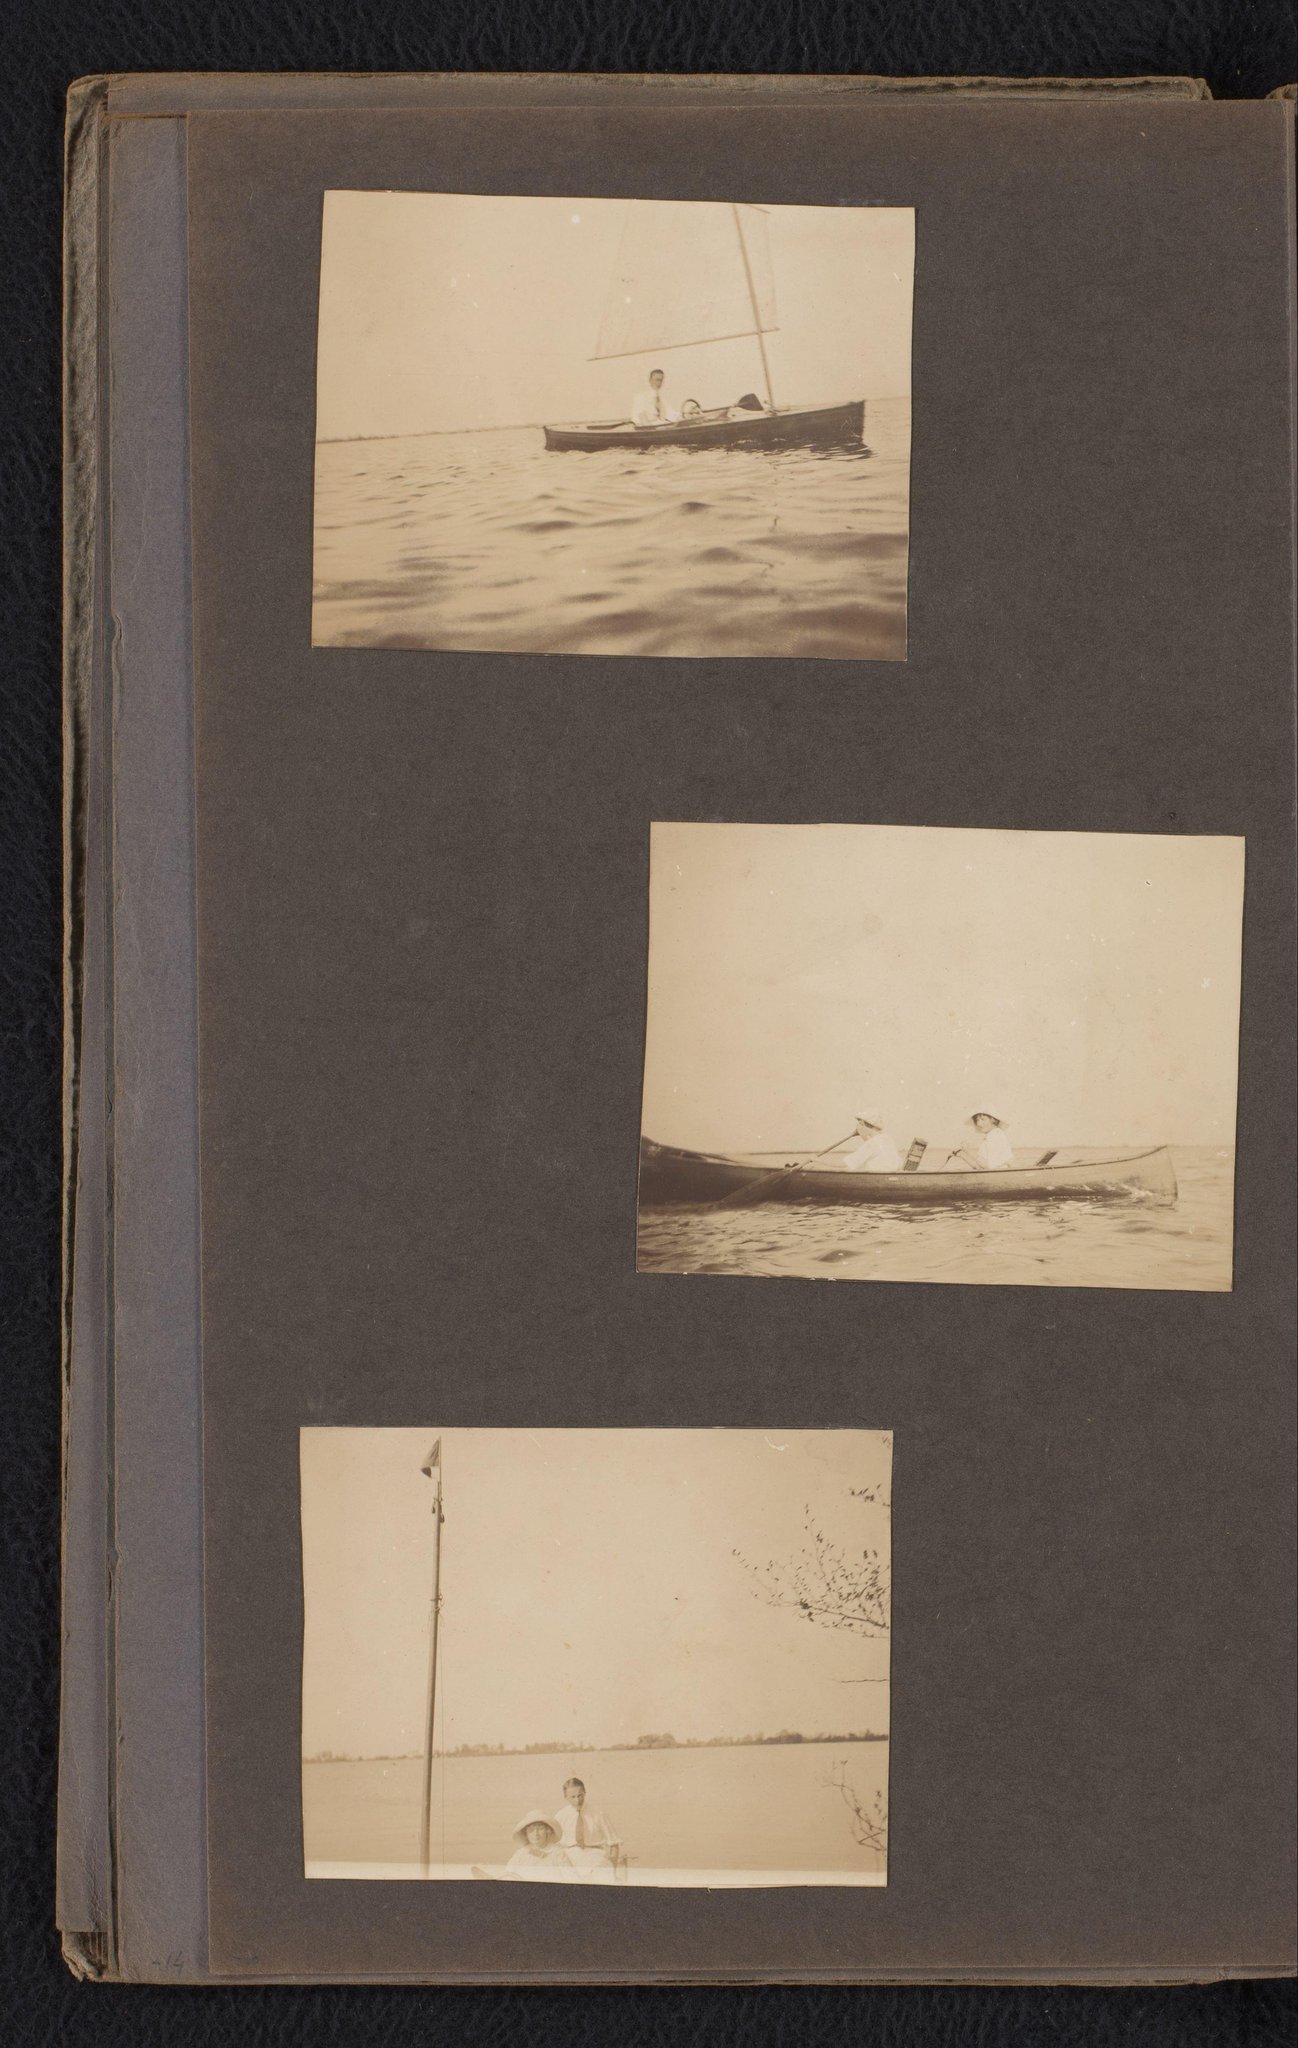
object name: photograph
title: Drie mensen in een zeilboot op een meer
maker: carolina frederika onnen (lien/loen)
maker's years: 1896-1983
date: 1912-1913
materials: paper, cardboard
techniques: gelatin silver print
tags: sailing-ship, sailing-boat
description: Deze foto's zijn onderdeel van een album.